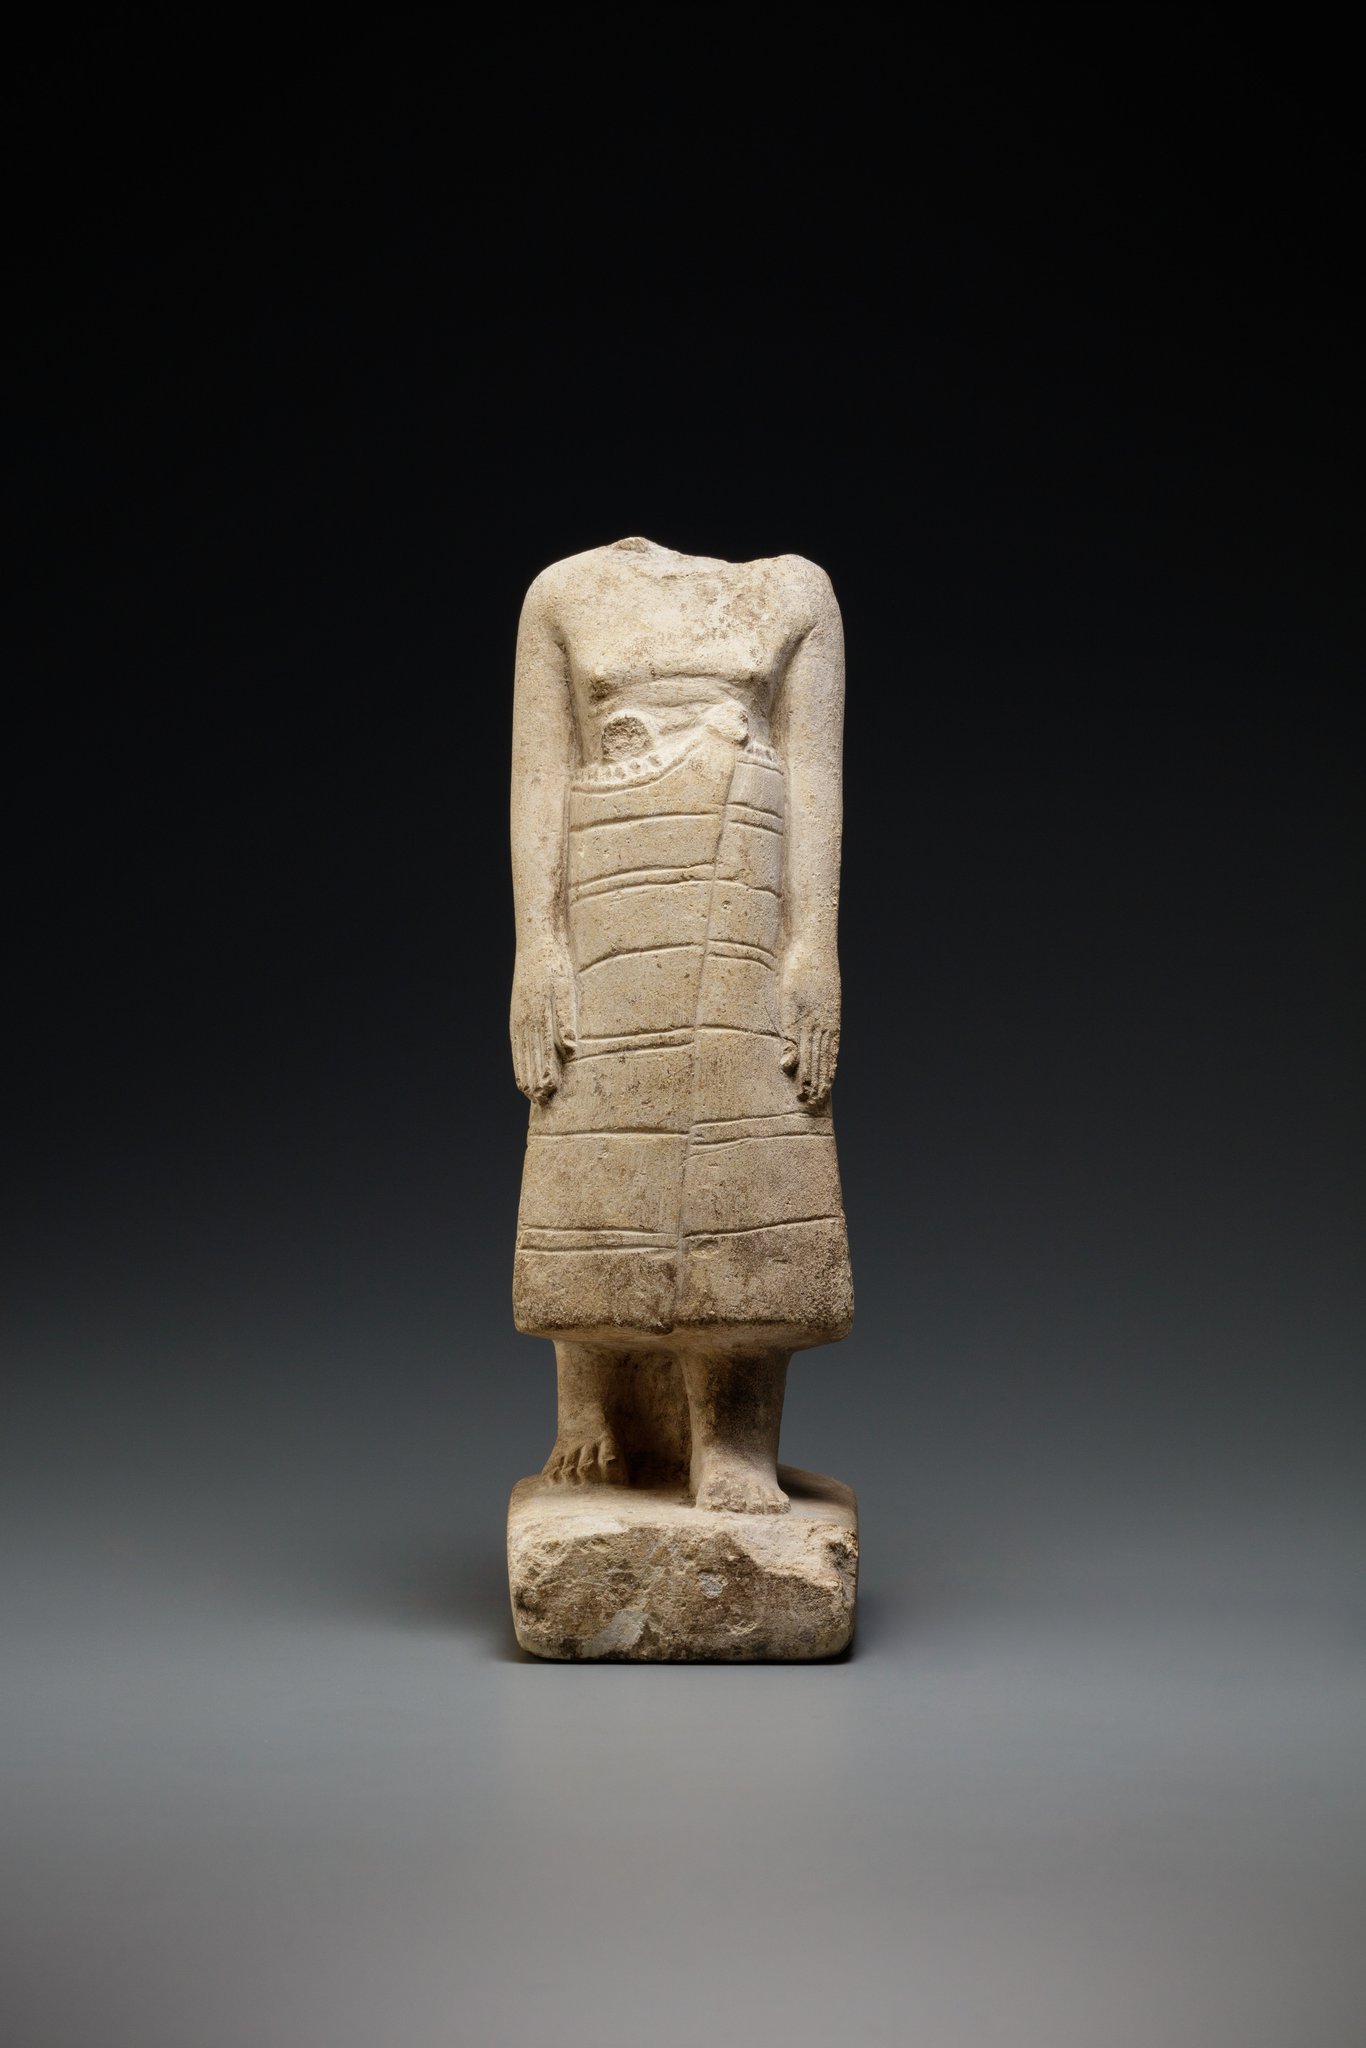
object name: statue, vizier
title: Statuette of the Vizier Iuy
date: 1700 BCE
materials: limestone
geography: egypt